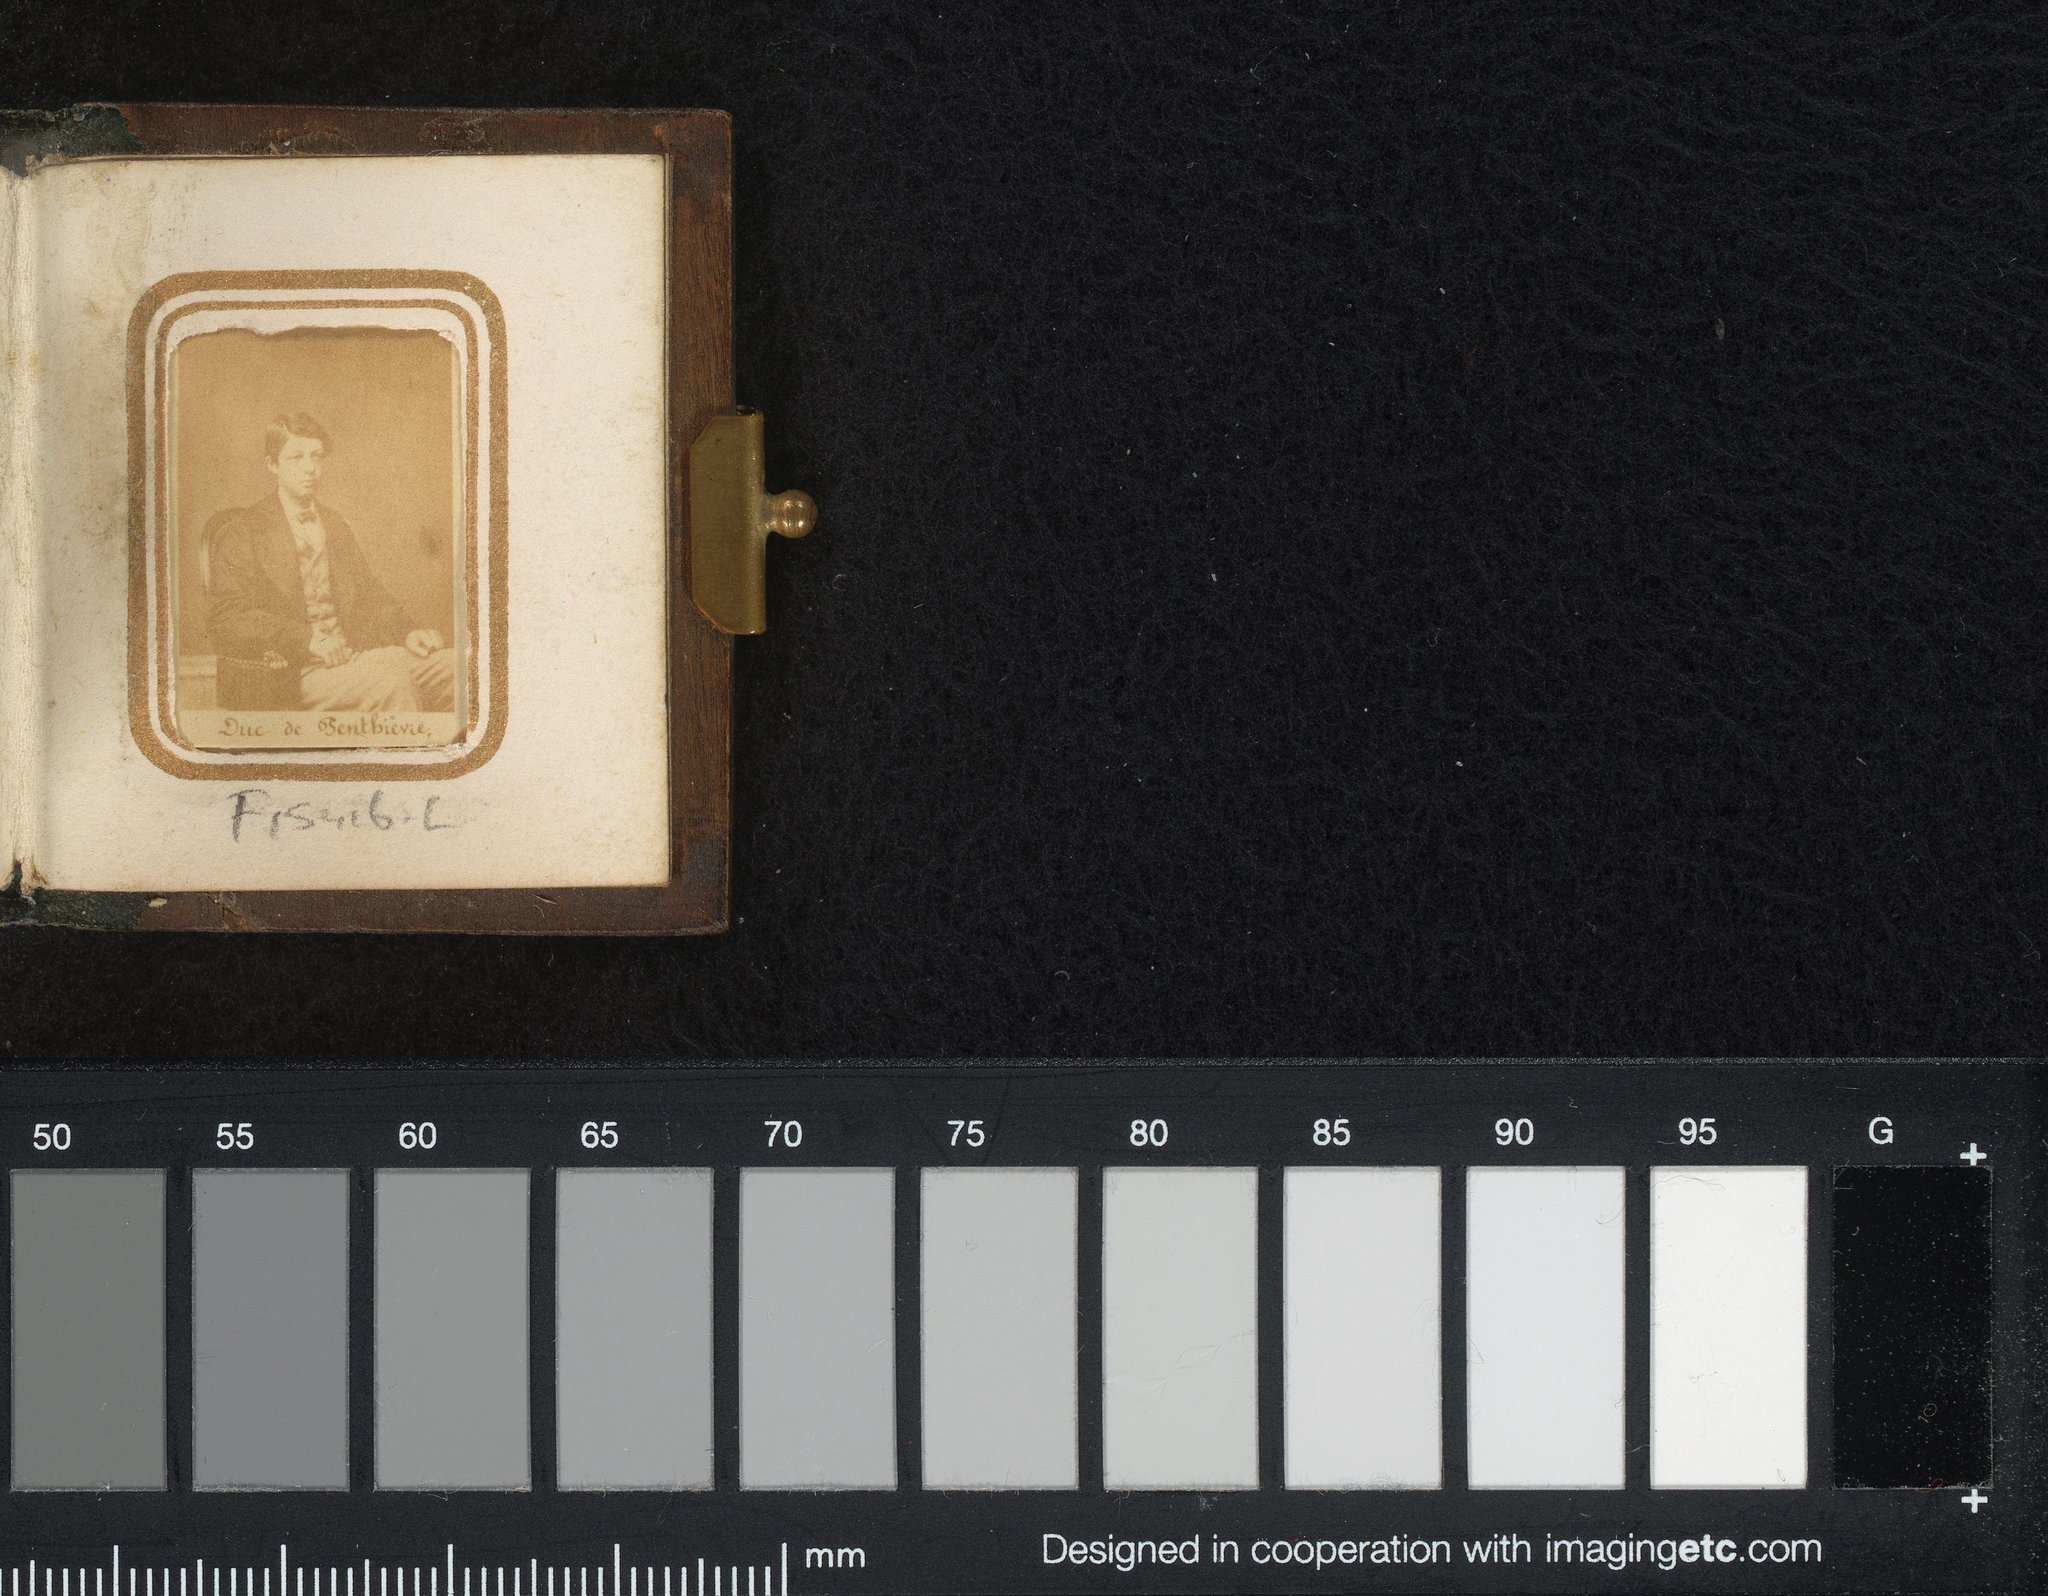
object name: photograph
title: Fotoreproductie van een portret van Pierre d'Orléans, hertog van Penthièvre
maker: Anonymous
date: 1851-1900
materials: paper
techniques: albumen print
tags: historical persons, nobility and patriciate; chivalry, knighthood